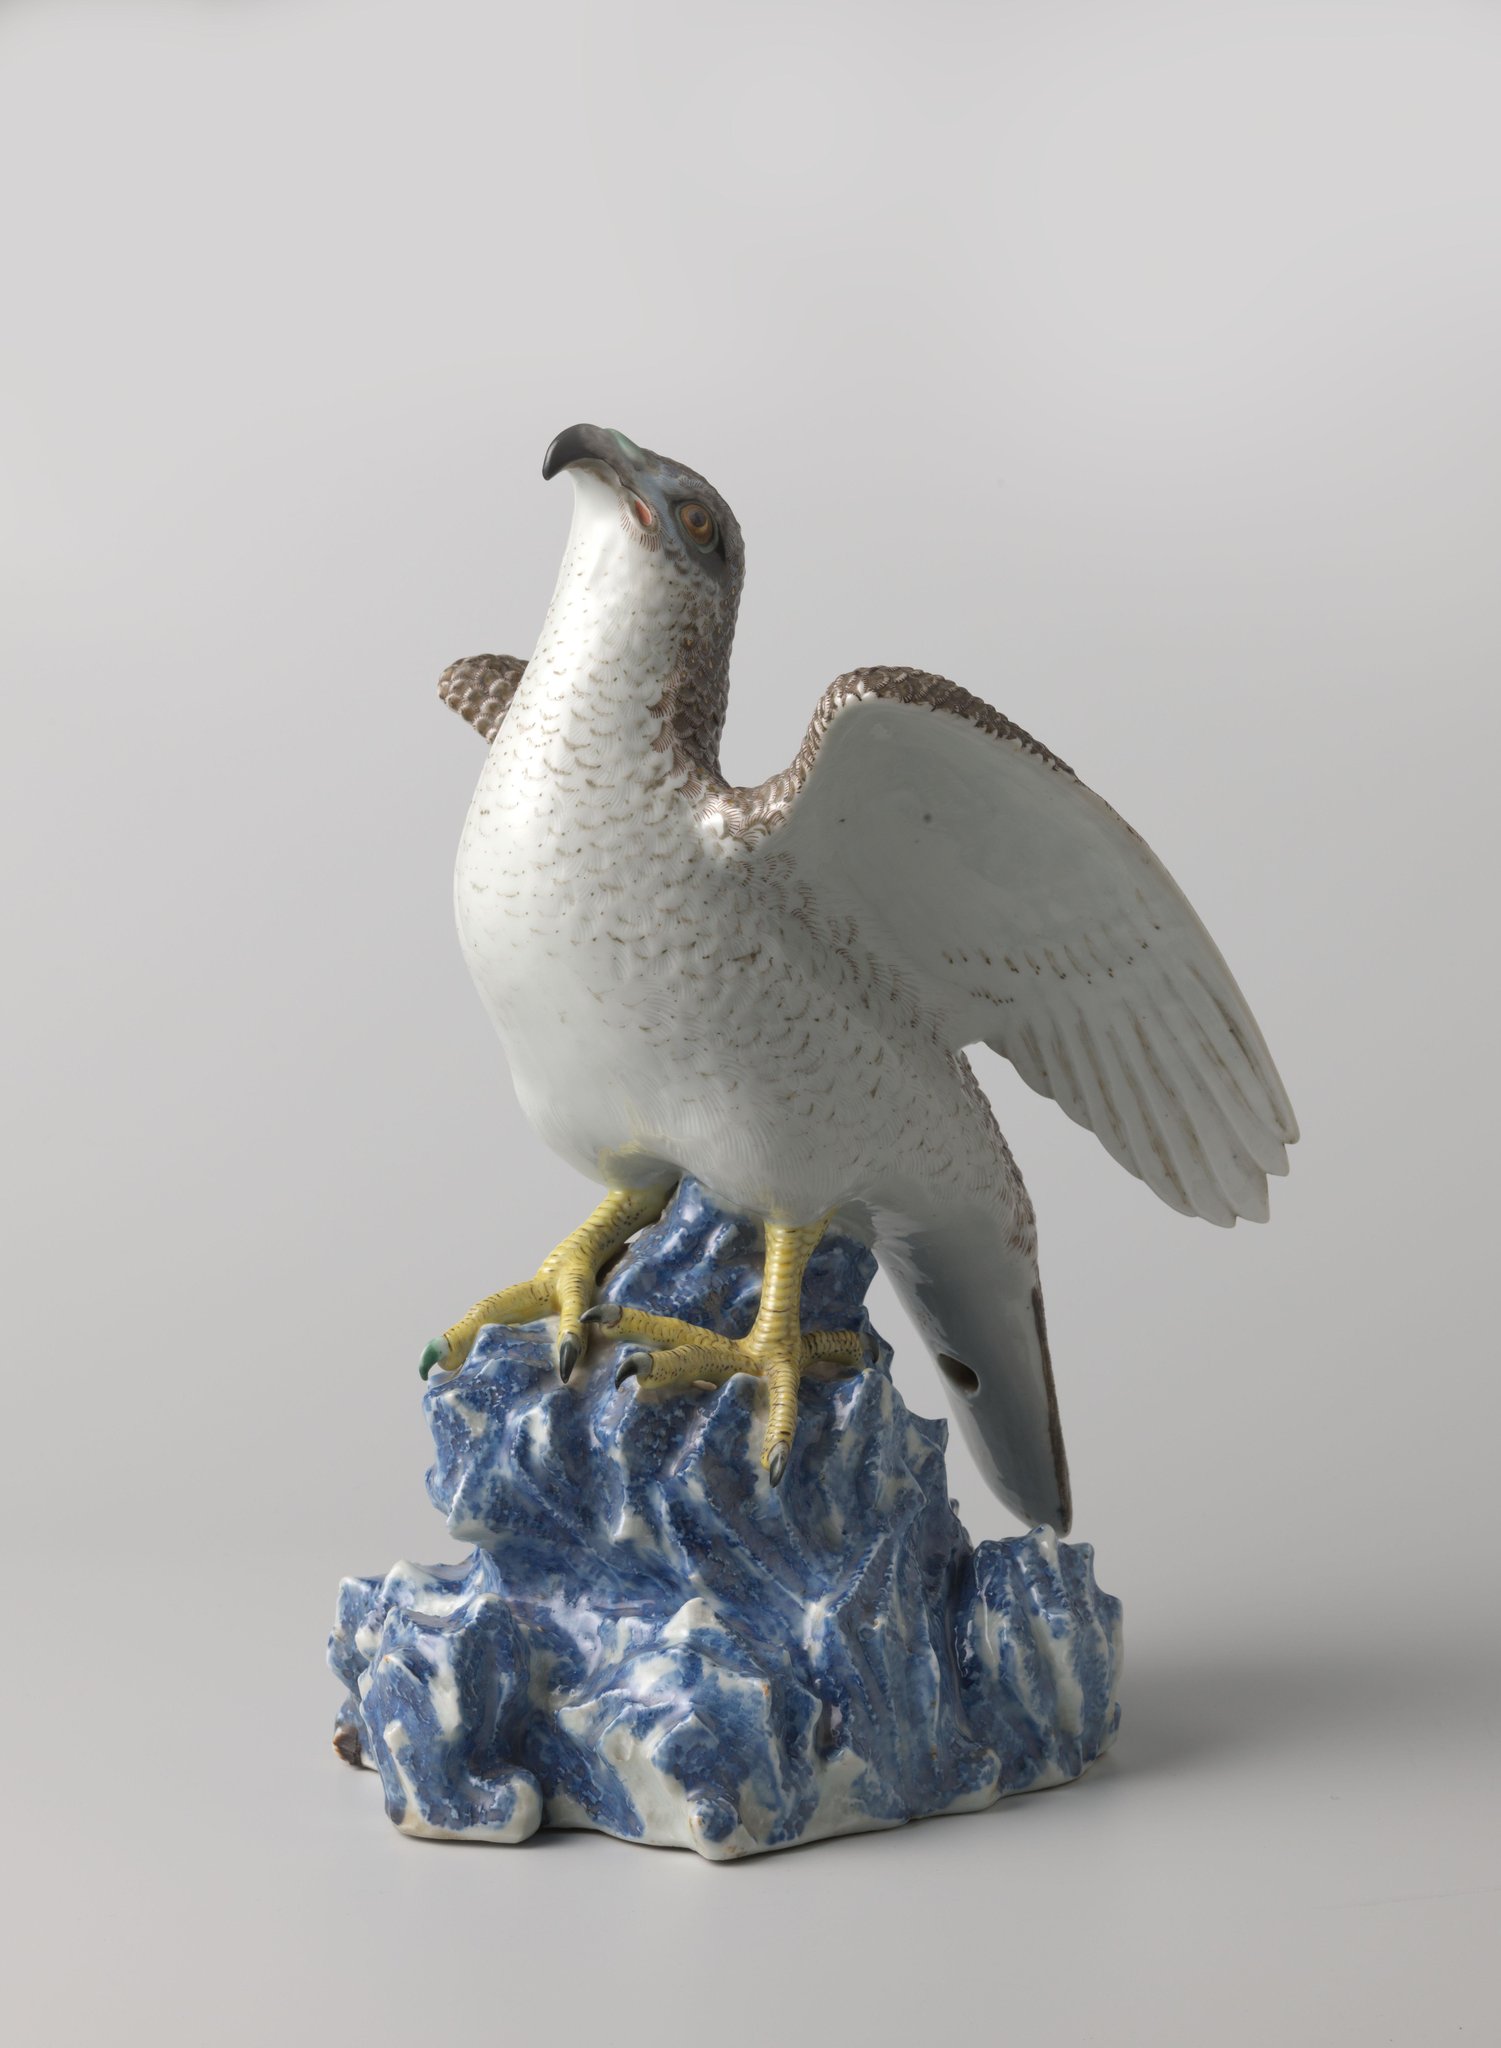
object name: dierfiguur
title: Figure of a bird of prey on a rock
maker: Anonymous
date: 1800-1899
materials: cobalt, glaze, gold, paint, porcelain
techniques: firing, forming, gilding, vitrification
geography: china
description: Beeld van porselein, beschilderd in onderglazuur blauw en op het glazuur blauw, rood, groen, geel, bruin, zwart en goud. Beeld van een roofvogel staande op een rots met de vleugels licht gespreid en de kop omhoog. Enkele bakscheuren. Porselein met emailkleuren.